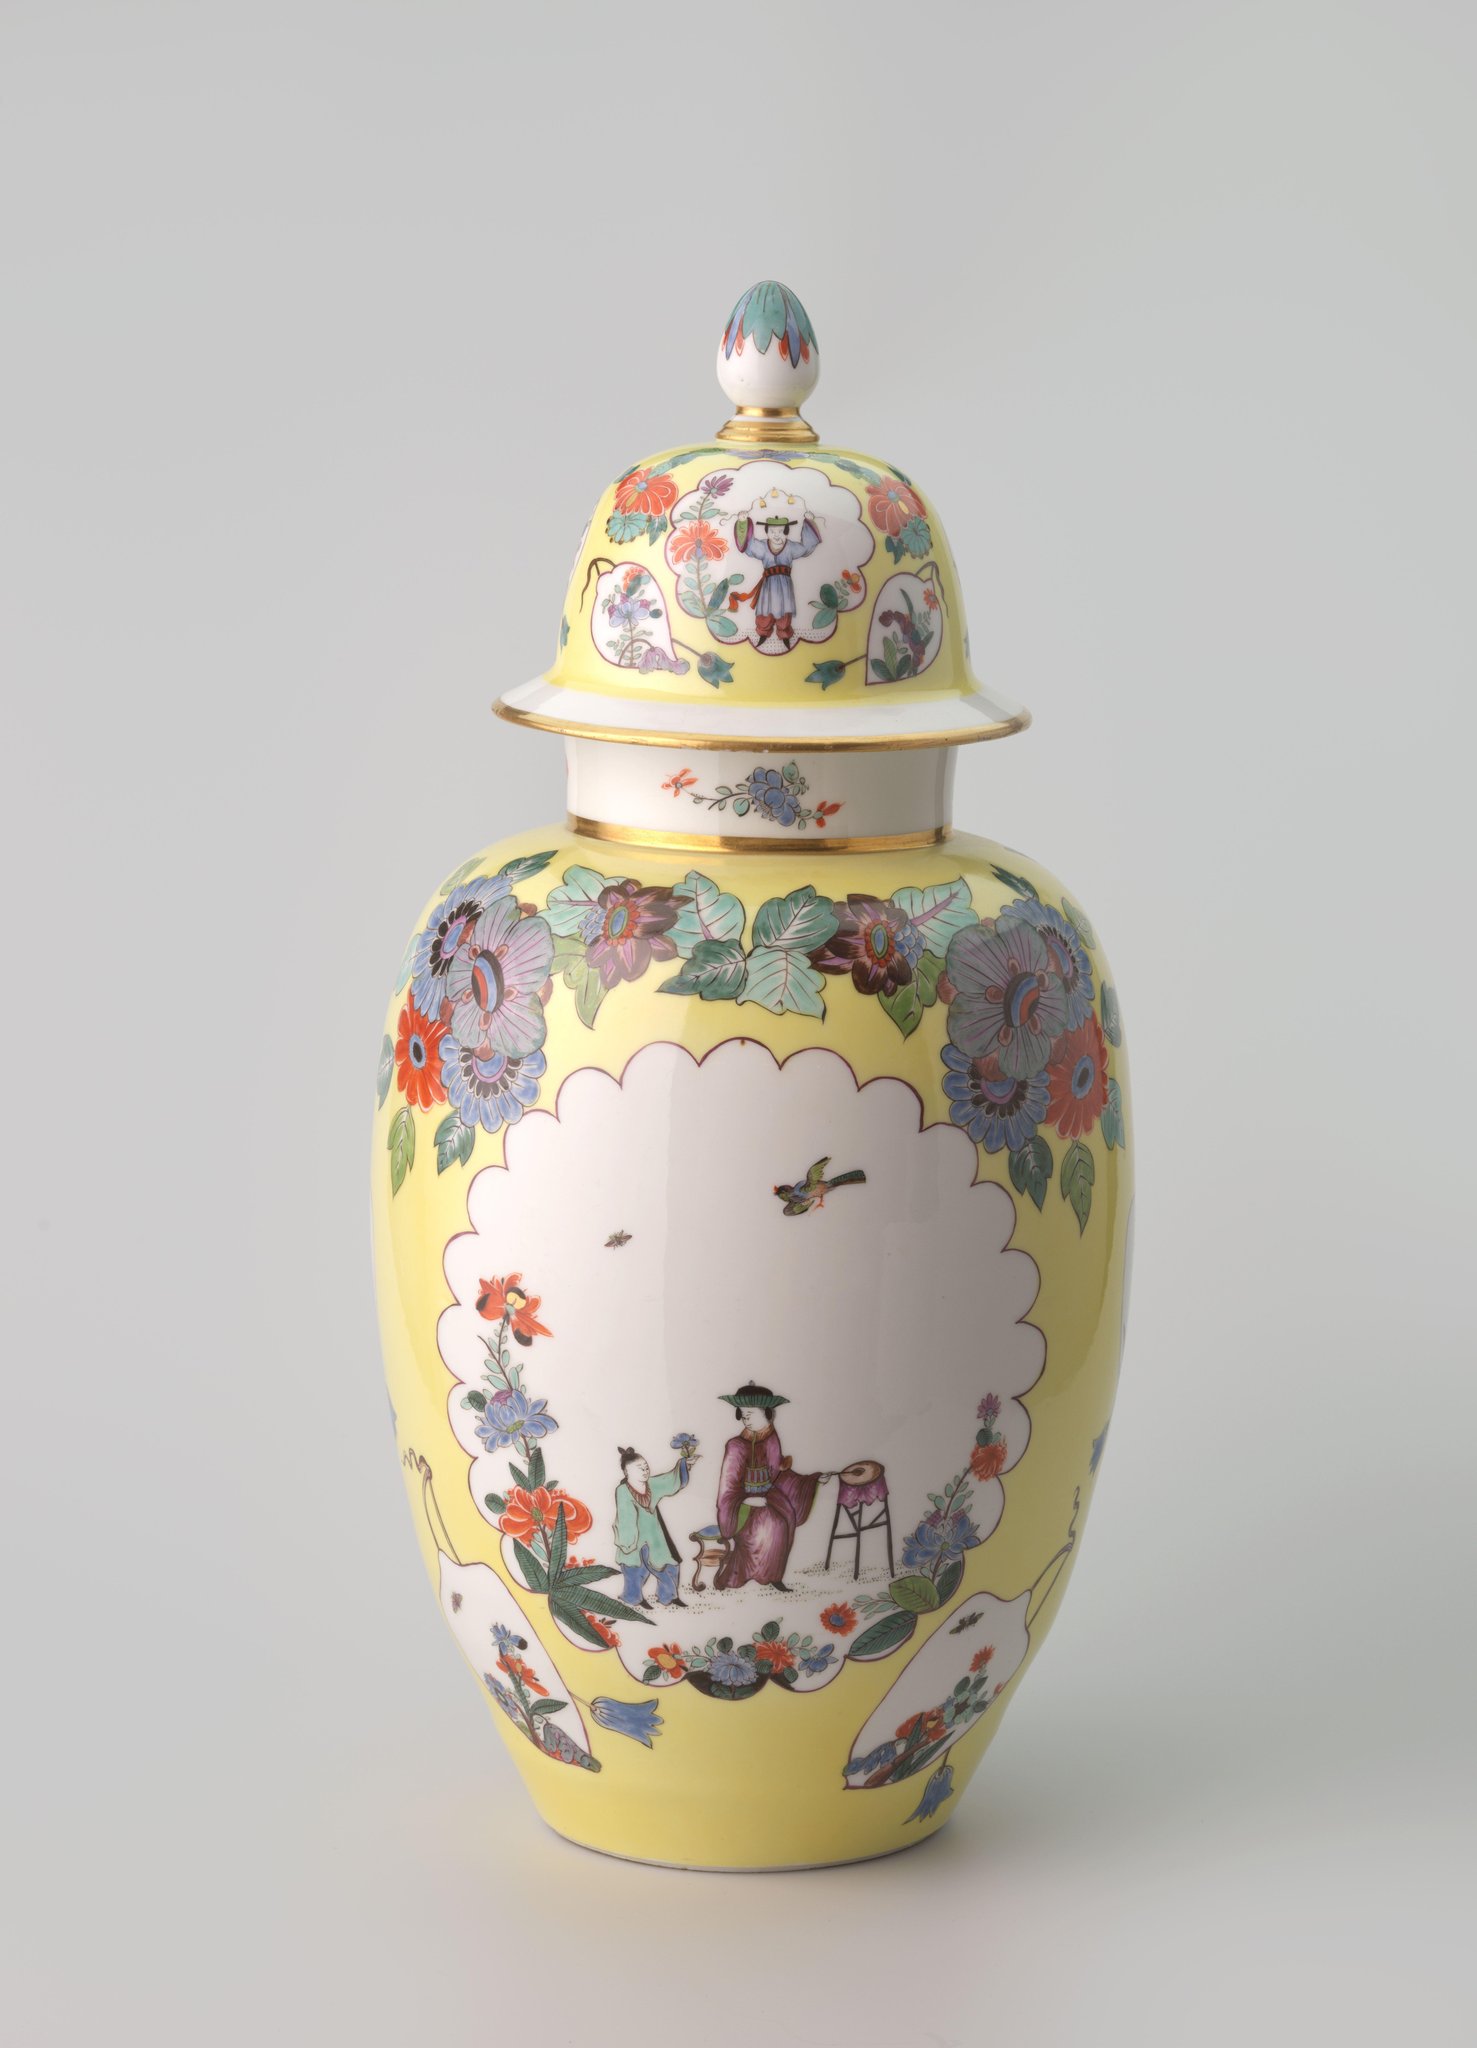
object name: vase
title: Vaas, veelkleurig beschilderd met Chinezen in uitgespaarde gelobde cirkels in een gele fond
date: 1735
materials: porcelain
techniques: painted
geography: meissen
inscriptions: number: ‘259.’, label: ‘SAMMLUNG / Dr. FRANZ OPPENHEIMER’, factory mark: ‘AR’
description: Vaas van beschilderd porselein. De vaas is op de hals na bedekt met een gele fond, waarin op het lichaam en het deksel twee guirlandes van Indianische Blumen zijn geschilderd. In de gele fond zijn uitgespaard twee grote bijna cirkelvormige velden met gelobde randen, waarin contour-chinoiserieën zijn geschilderd en zes peervormige velden met vogels en bloemen. De vaas is gemerkt.